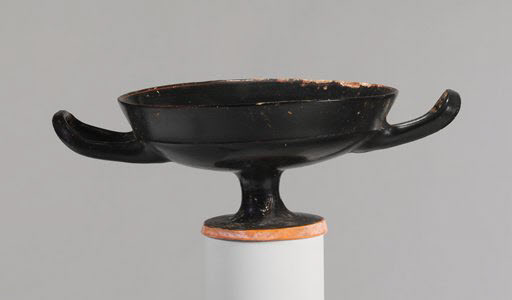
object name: kylix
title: Terracotta kylix (drinking cup)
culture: greek, attic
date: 475-450 BCE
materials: terracotta